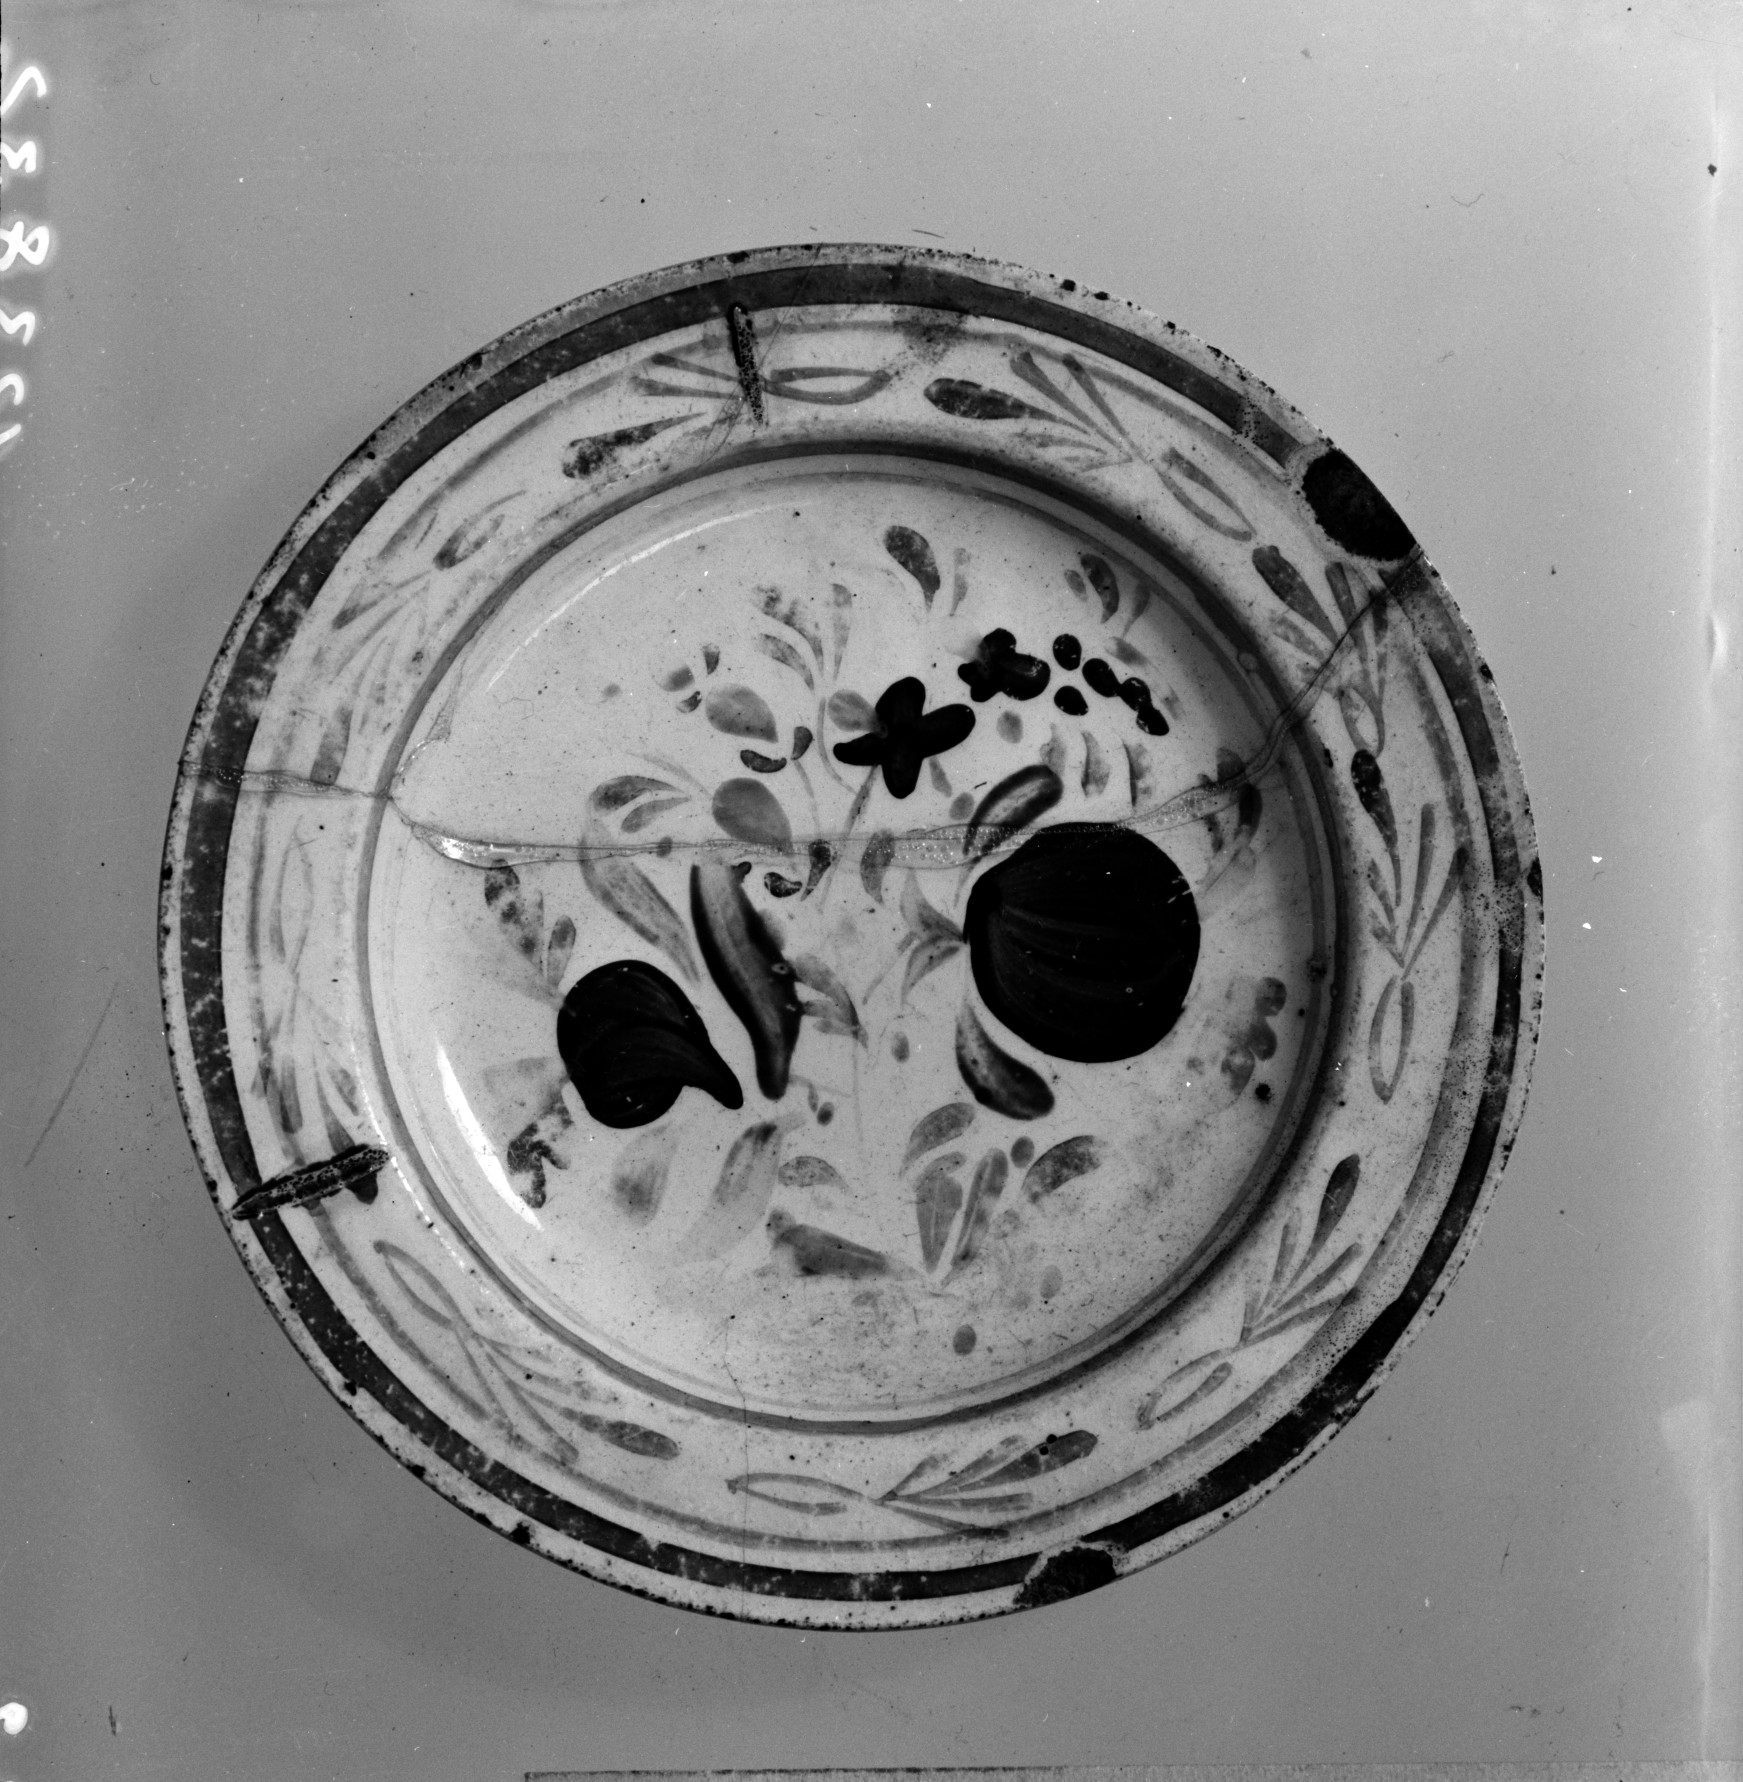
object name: plate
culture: british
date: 1825-1850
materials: earthenware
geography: england